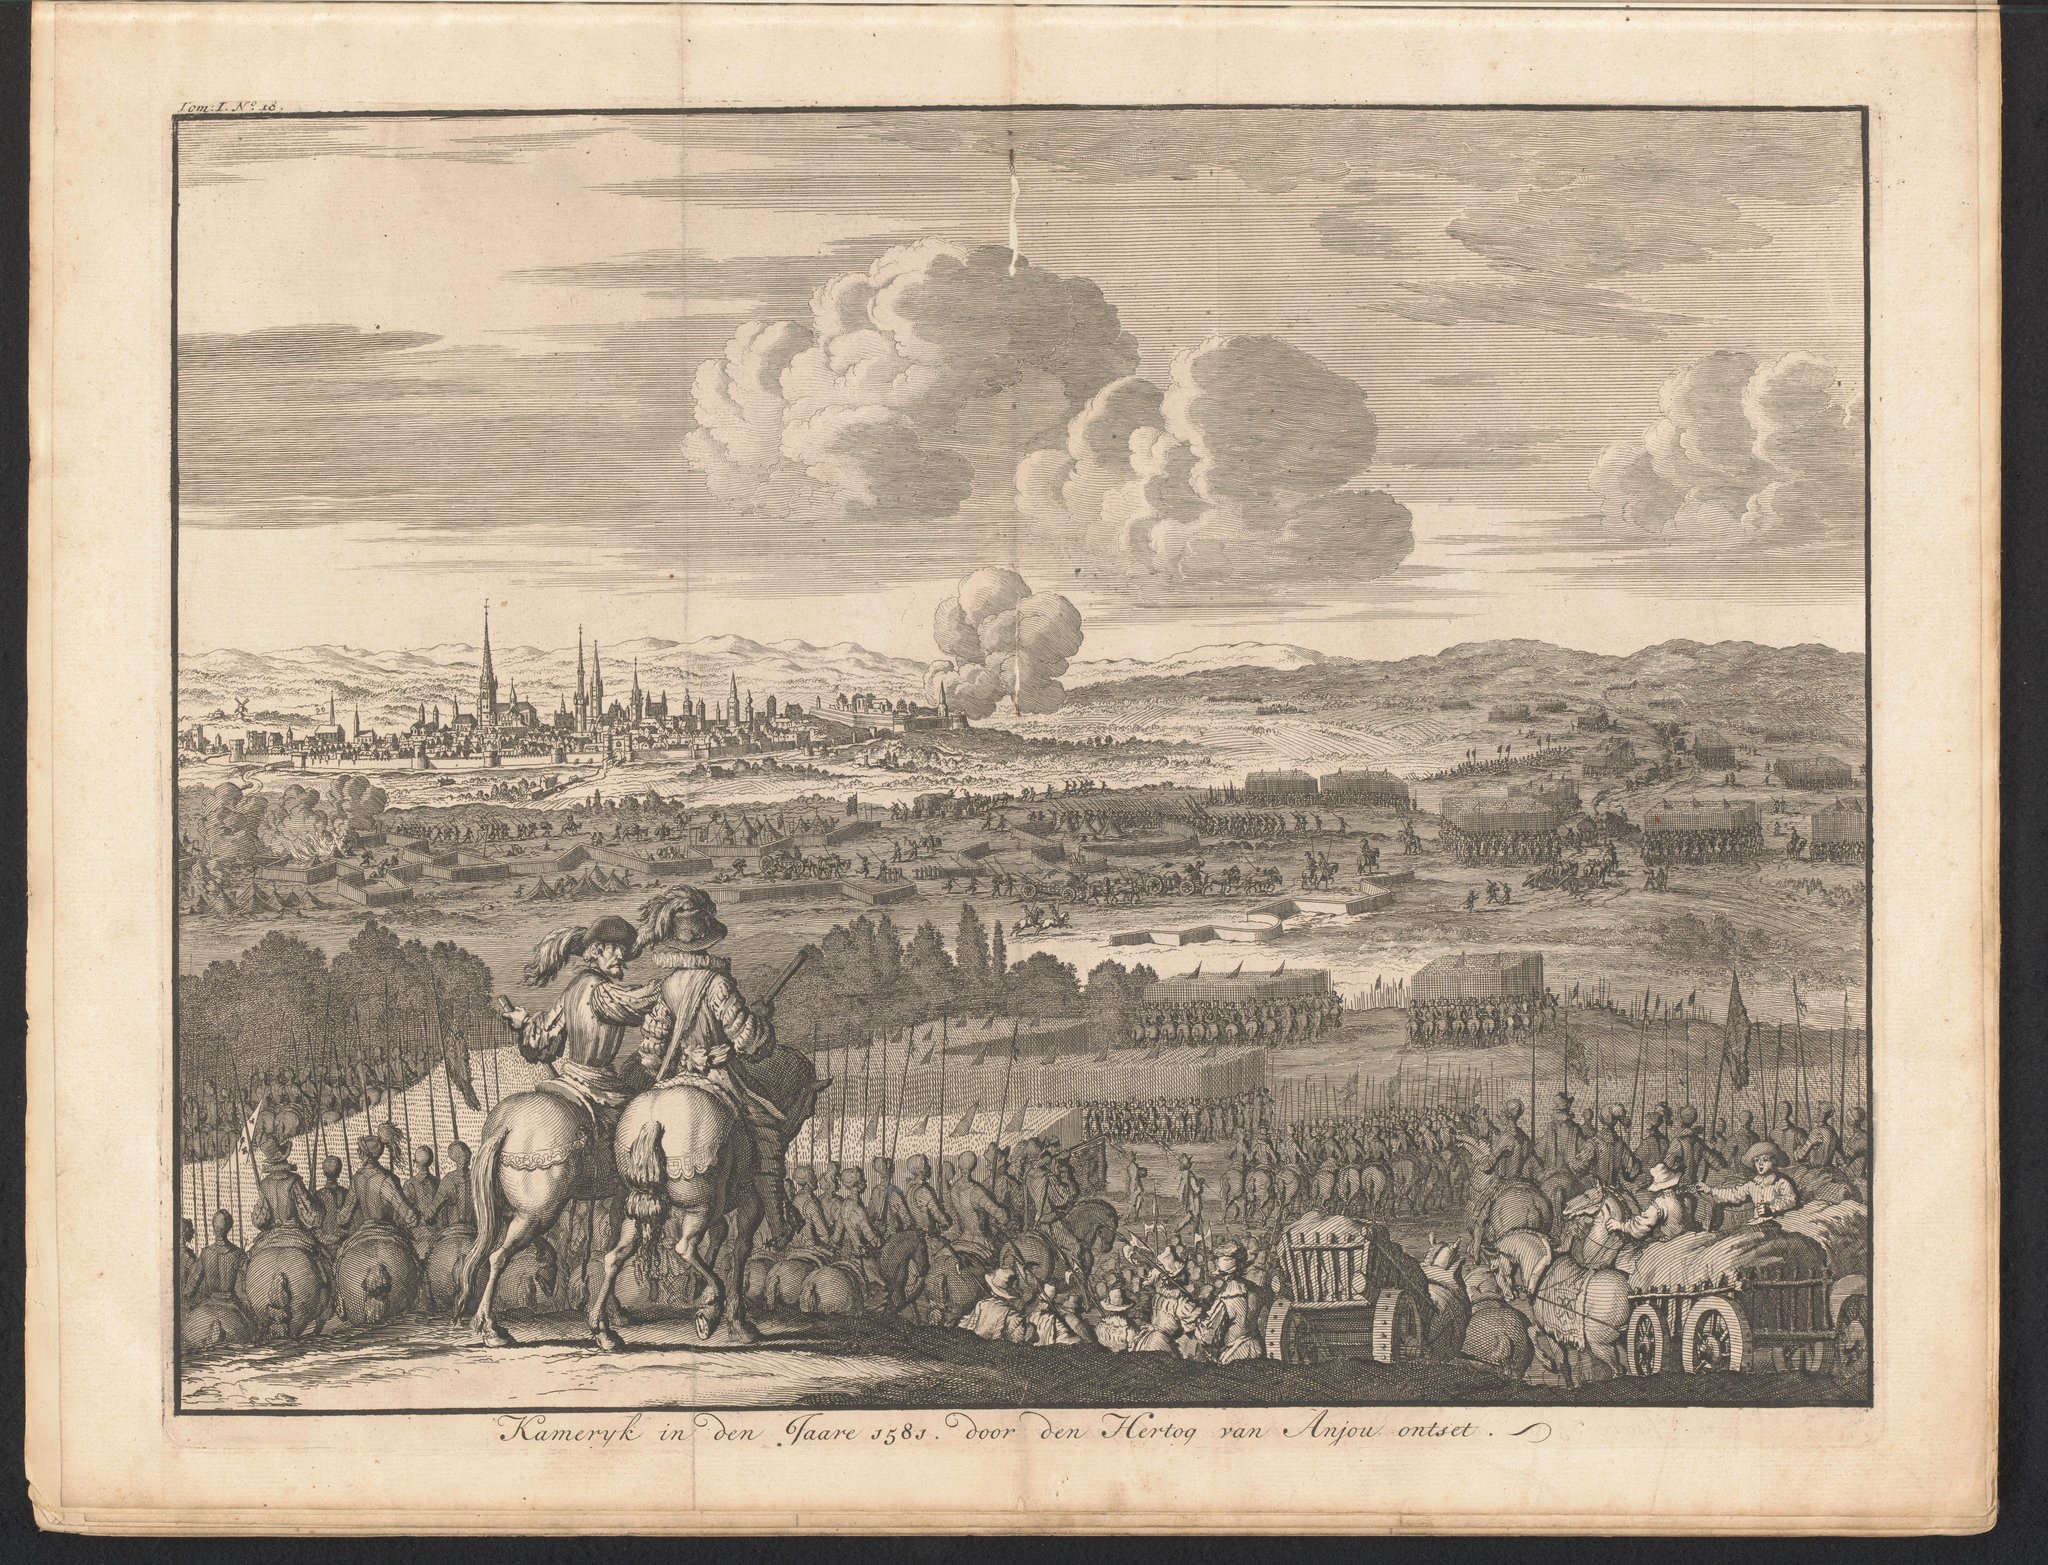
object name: album leaf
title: Het ontzet van Kamerijk door de hertog van Anjou, 1581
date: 1730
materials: paper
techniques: etching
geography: northern netherlands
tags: paris, françois-hercule de valois (hertog van anjou), rome, alessandro farnese (landvoogd van de nederlanden en hertog van parma en piacenza), raising the siege with outside assistance, relief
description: Prent waarschijnlijk uit: Le Clerc, Jean. Geschiedenissen der Vereenigde Nederlanden, sedert den aanvang van die Republyk tot op den Vrede van Utrecht in 't jaar 1713 en het Tractaat van Barriere in 't jaar 1715 gesloten. Amsterdam: Zacharias Chatelain, 1730, dl. 1, p. 132-133. Eerdere staat gebruikt in: Bor, Pieter Christiaensz. Oorsprongk, begin, en vervolgh der Nederlandsche Oorlogen (...). Amsterdam: weduwe van Joannes van Someren, Abraham Wolfgangh, Hendrick en Dirk Boom, 1684, dl. 2, p. 286. Eerdere staat ook gebruikt in: Groot, Hugo de. Nederlandtsche Jaerboeken en Historien sedert het jaer MDLV tot het jaer MDCIX (...). Amsterdam: weduwe Joannes van Someren, Abraham Wolfgang en Hendrick en Dirk Boom, 1681, p. 76-77.